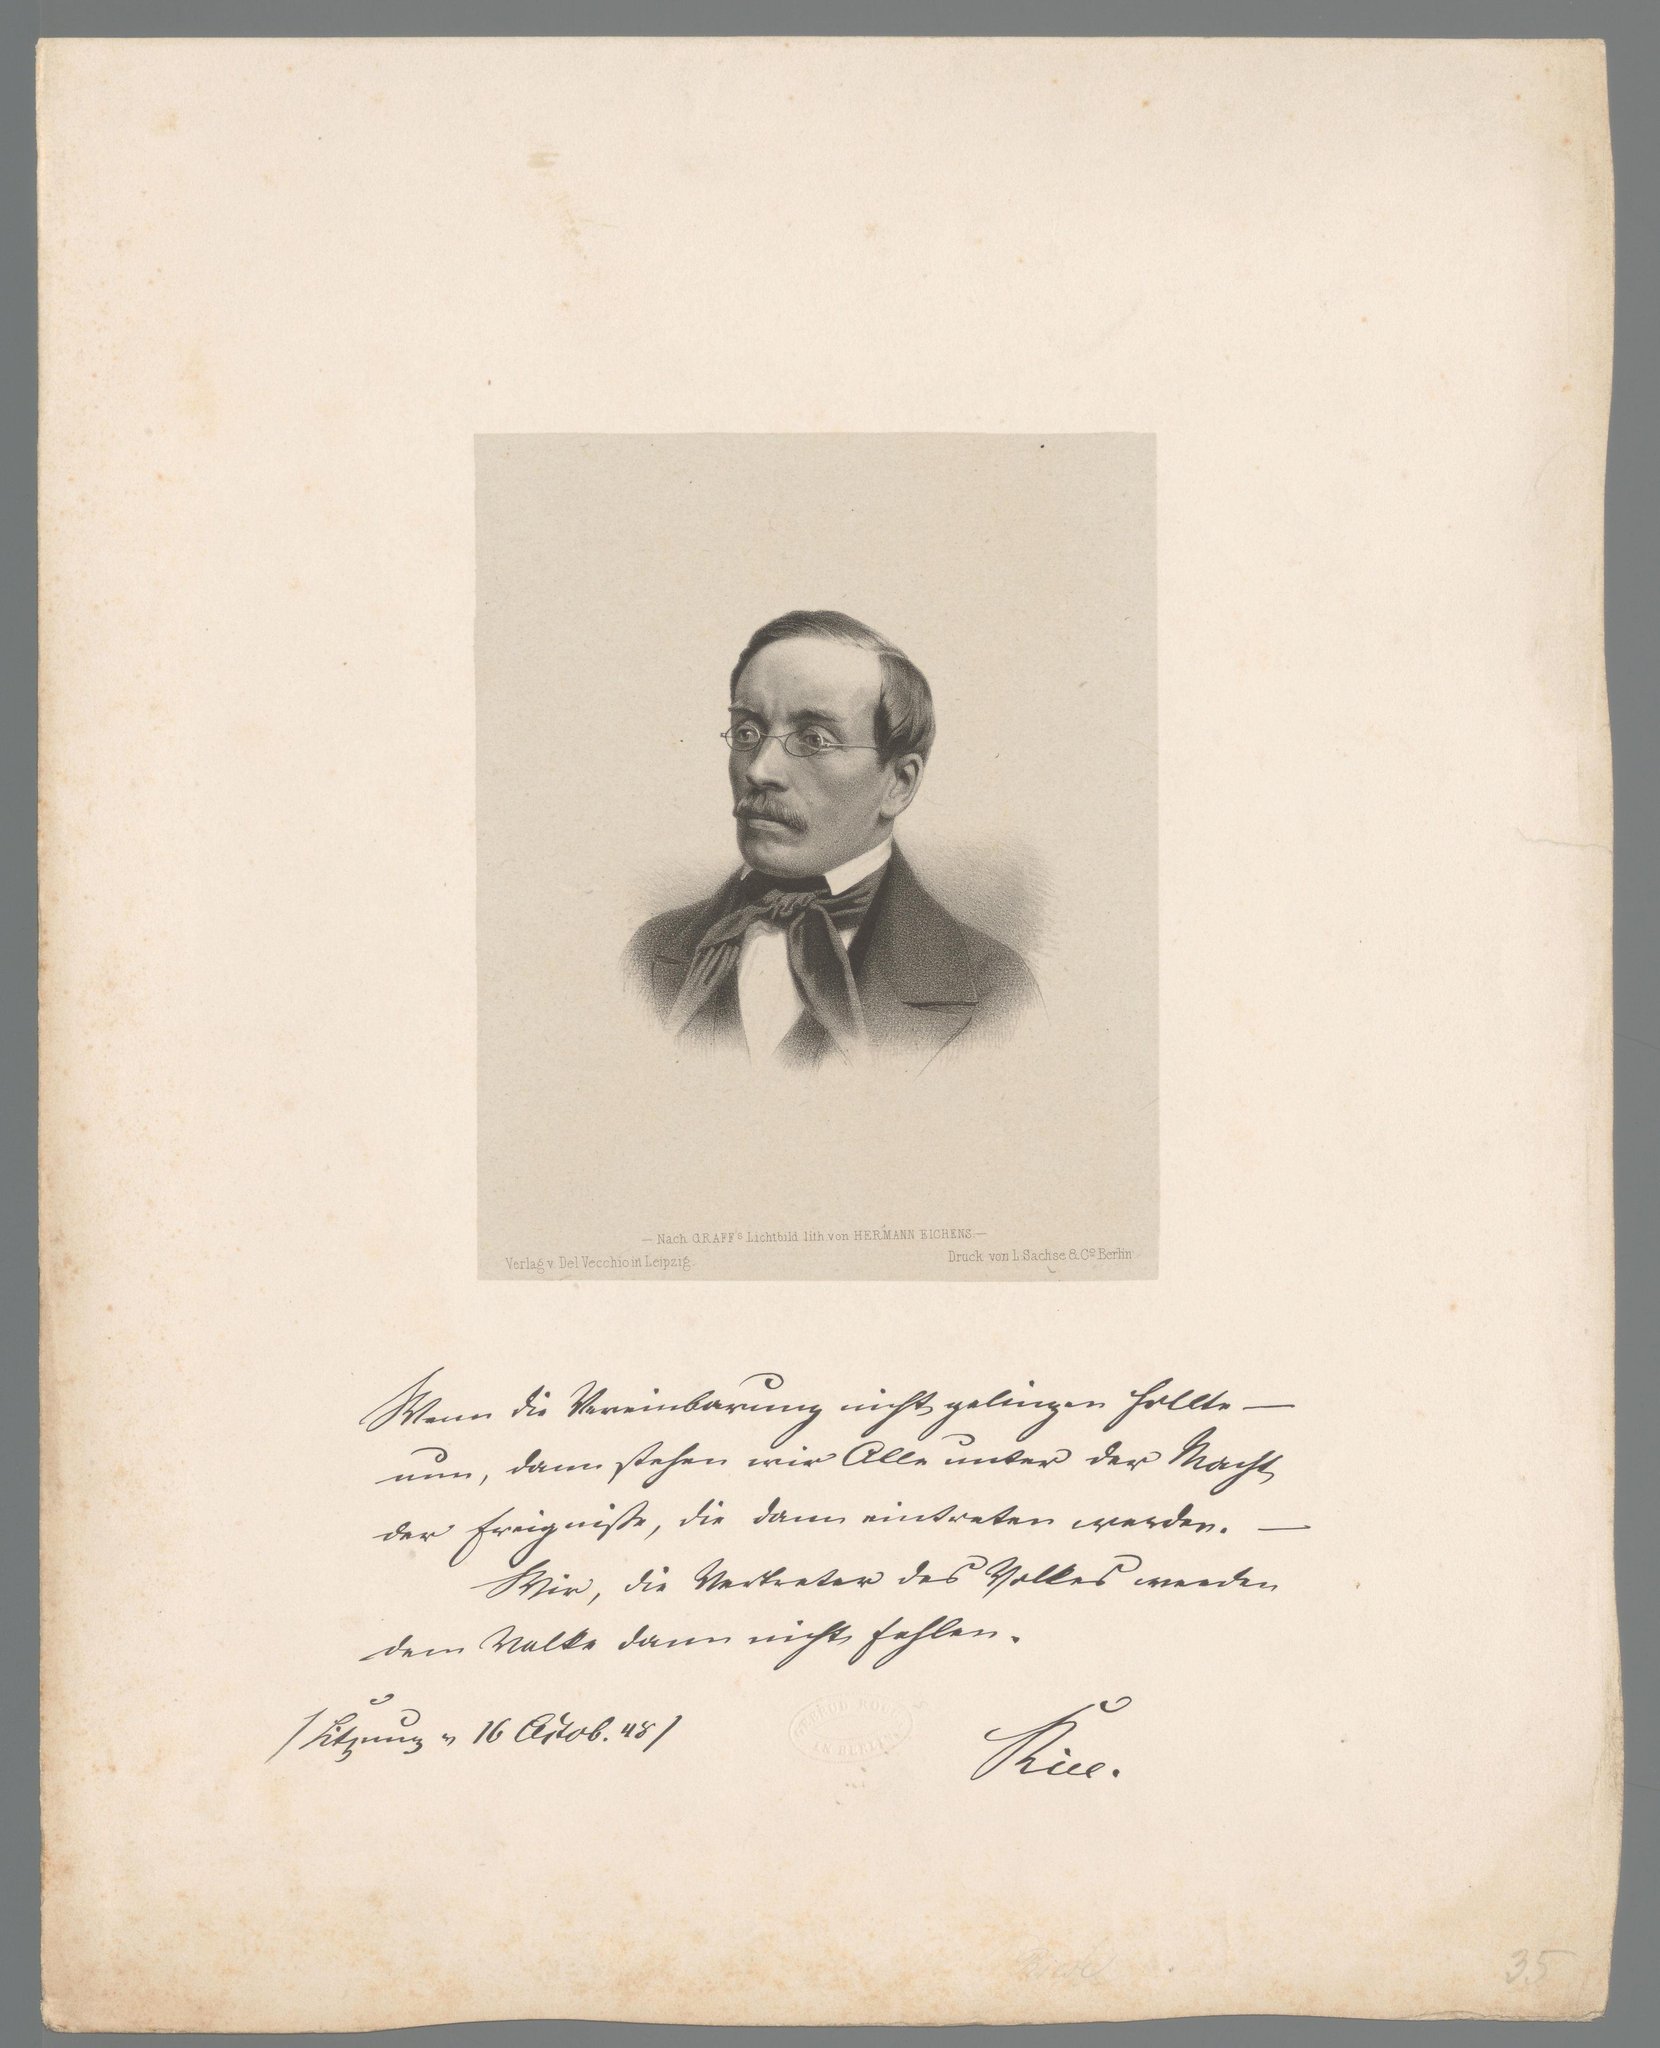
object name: print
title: Portret van een onbekende man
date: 1870-1886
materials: paper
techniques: lithograph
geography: berlin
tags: historical persons not known by name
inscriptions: collector's mark: Lugt 2228, check stamp: Lugt 2141c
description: Portret van een verder onbekende man, met handtekening in facsimile waarin de naam Riel, Rul of Rice te lezen is.